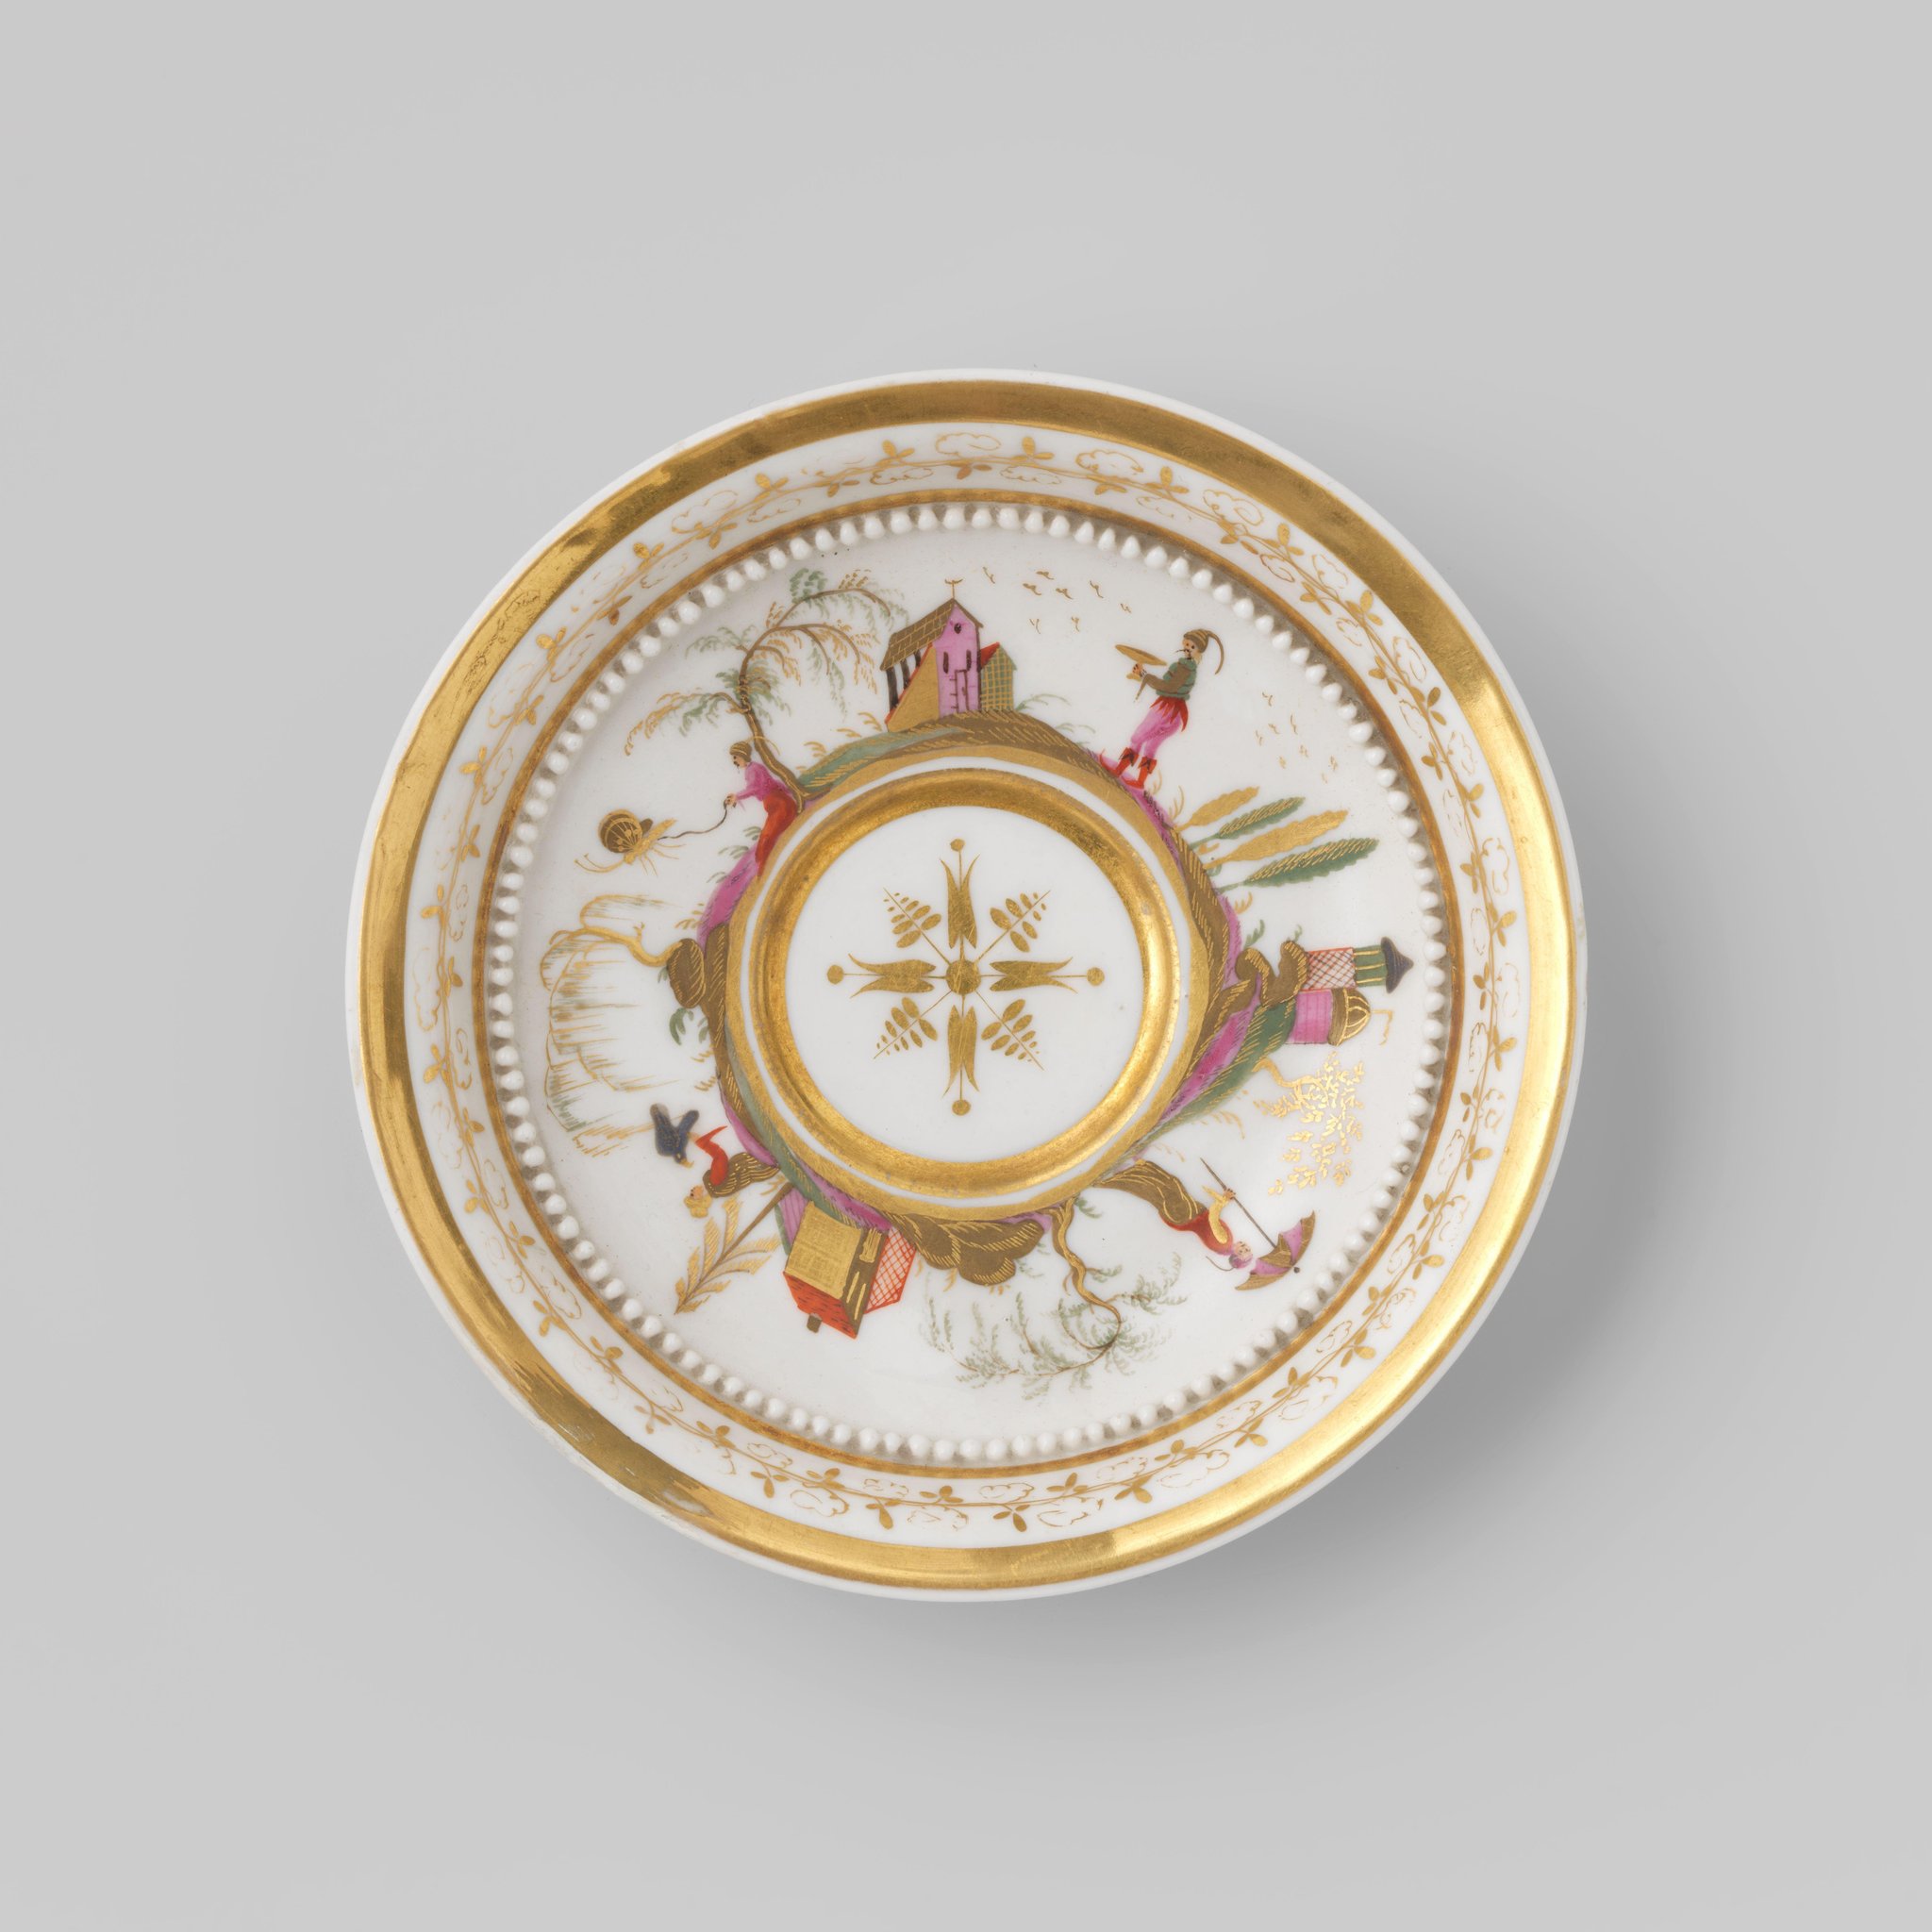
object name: platter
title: Saucer with figures in a landscape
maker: Anonymous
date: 1790-1800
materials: glaze, gold, paint, porcelain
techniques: firing, forming, gilding, turning, vitrification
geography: france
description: Schotel van porselein, beschilderd op het glazuur in blauw, rood, roze, groen, zwart en goud. Op het plat een rozet in een gouden medaillon. Om dit medaillon, doorlopend op de wand, een fantasielandschap met gebouwen, bomen en Aziatisch ogende personen (chinoiserie). Het tafereel wordt afgesloten door een band van kleine bollen in reliëf. Op de rand een bladrank. Gouden rand.